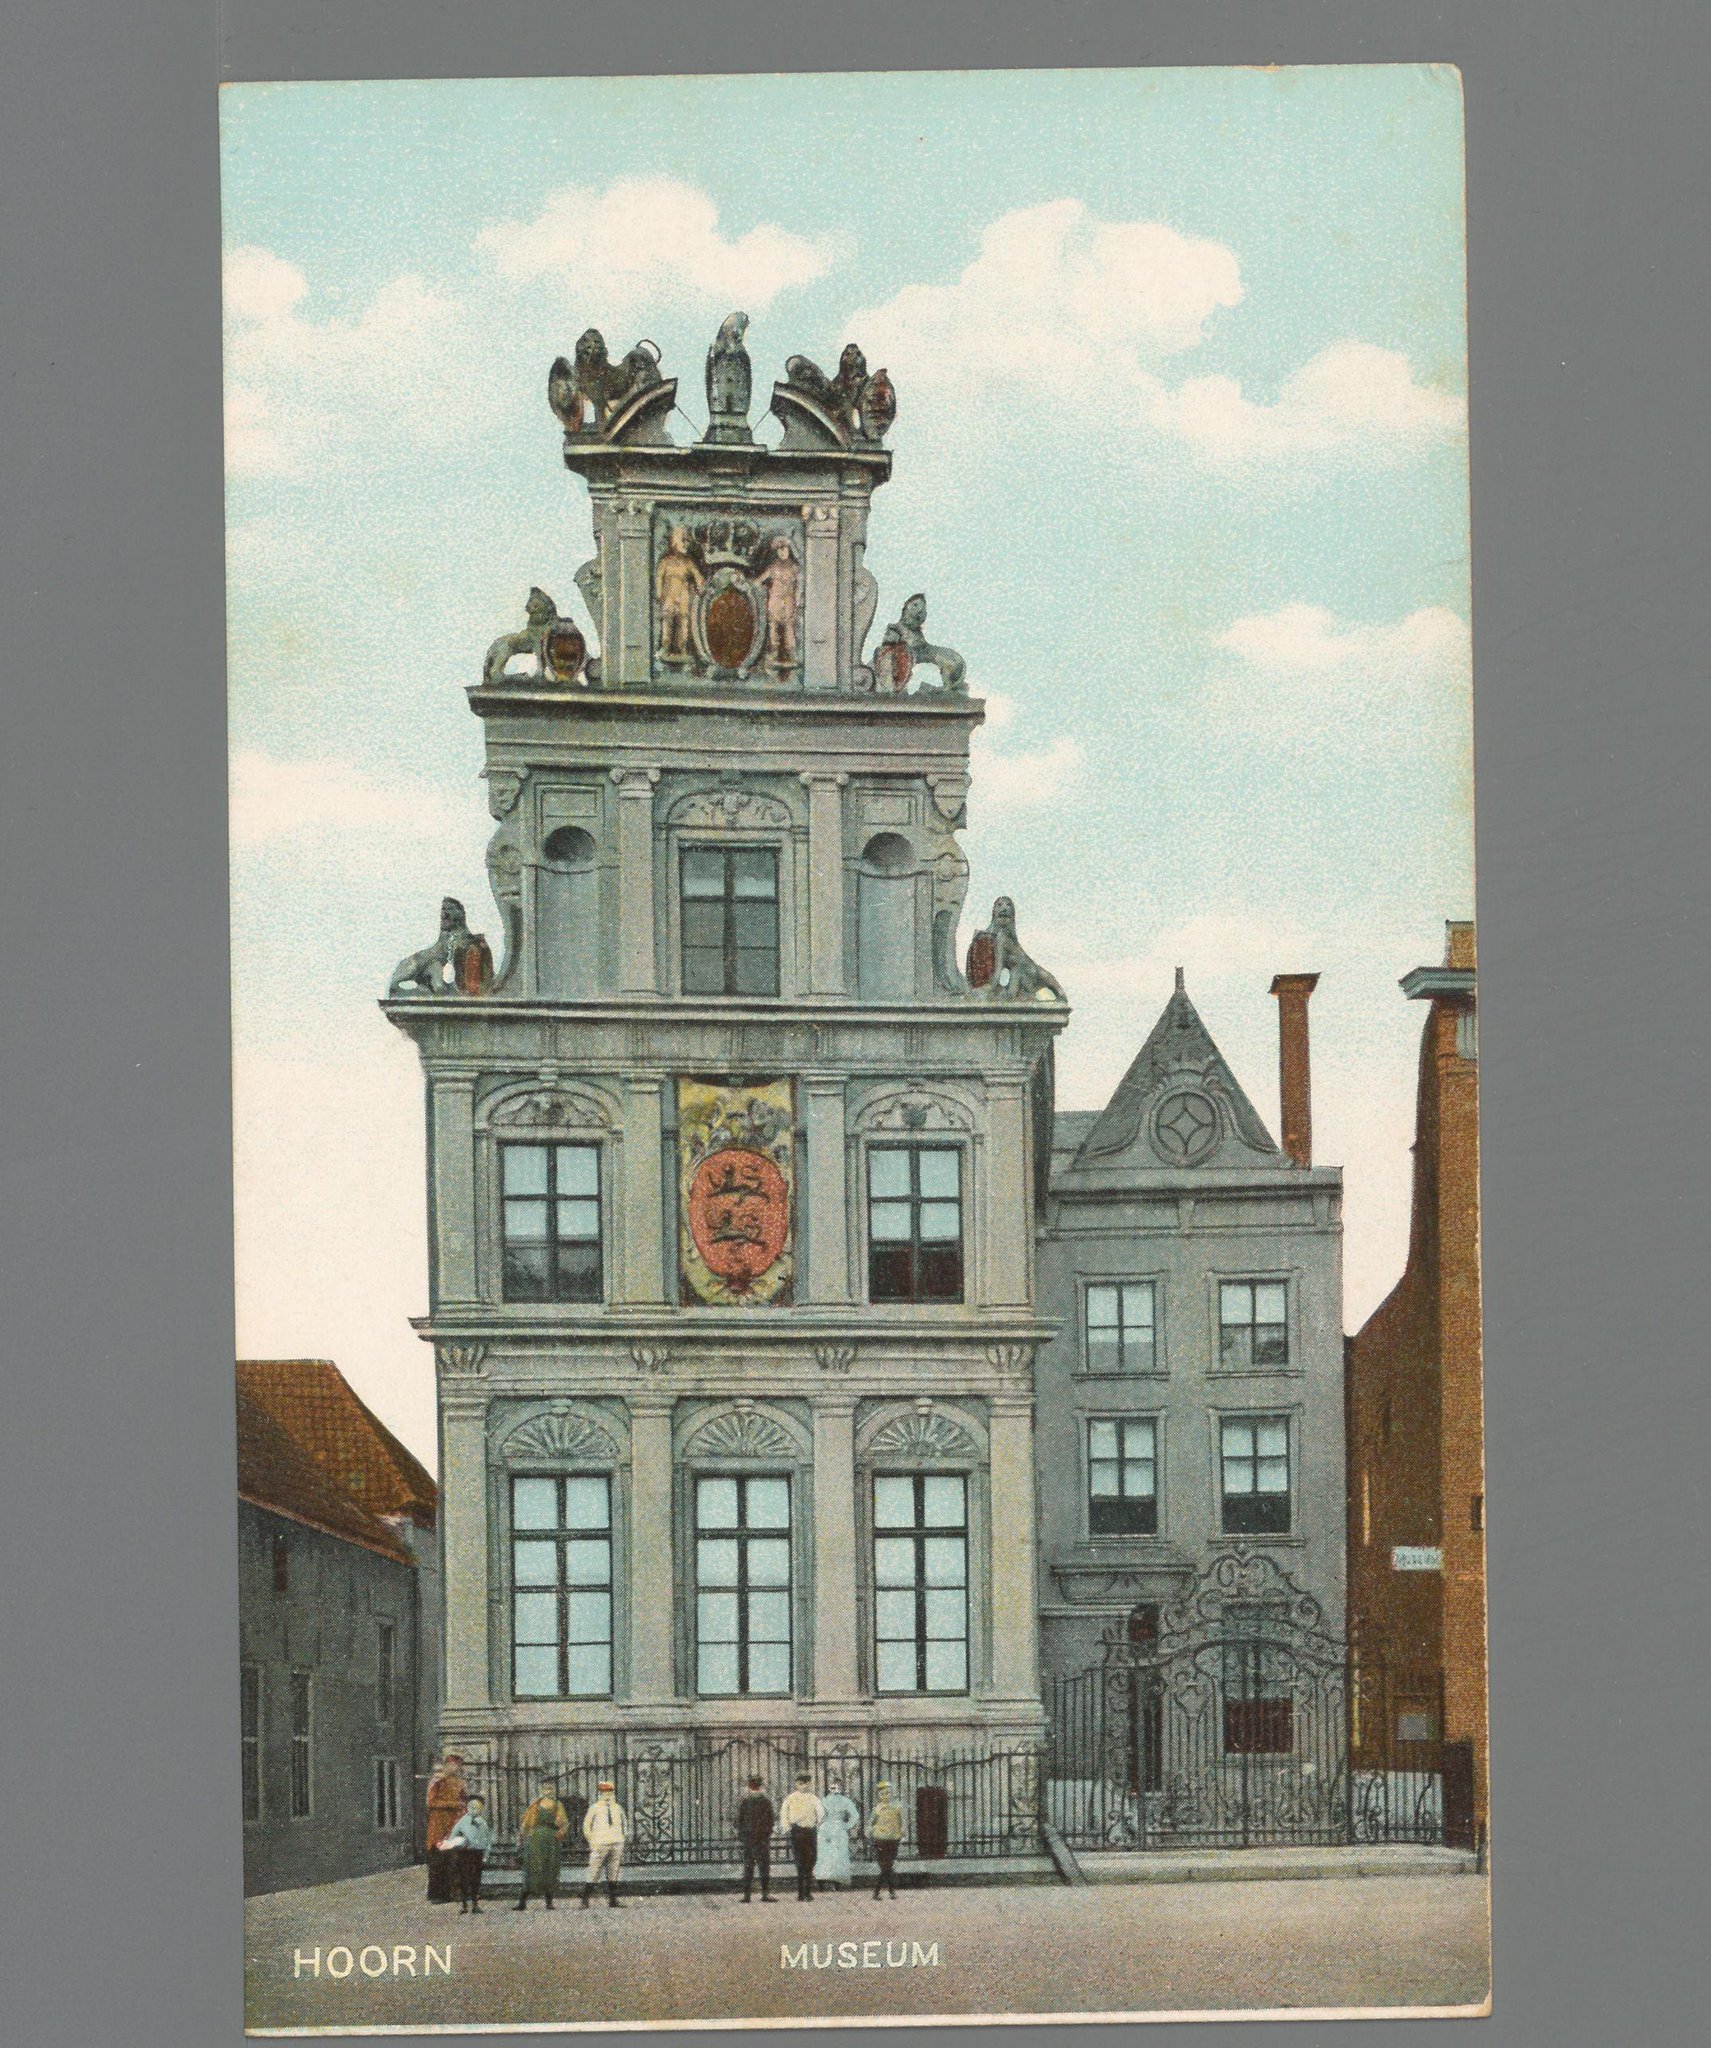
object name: ansichtkaart, prentbriefkaart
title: Hoorn. Museum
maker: Anonymous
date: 1906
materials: cardboard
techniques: lithograph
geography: leipzig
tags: permanent exhibition, museum, hoorn (north holland)